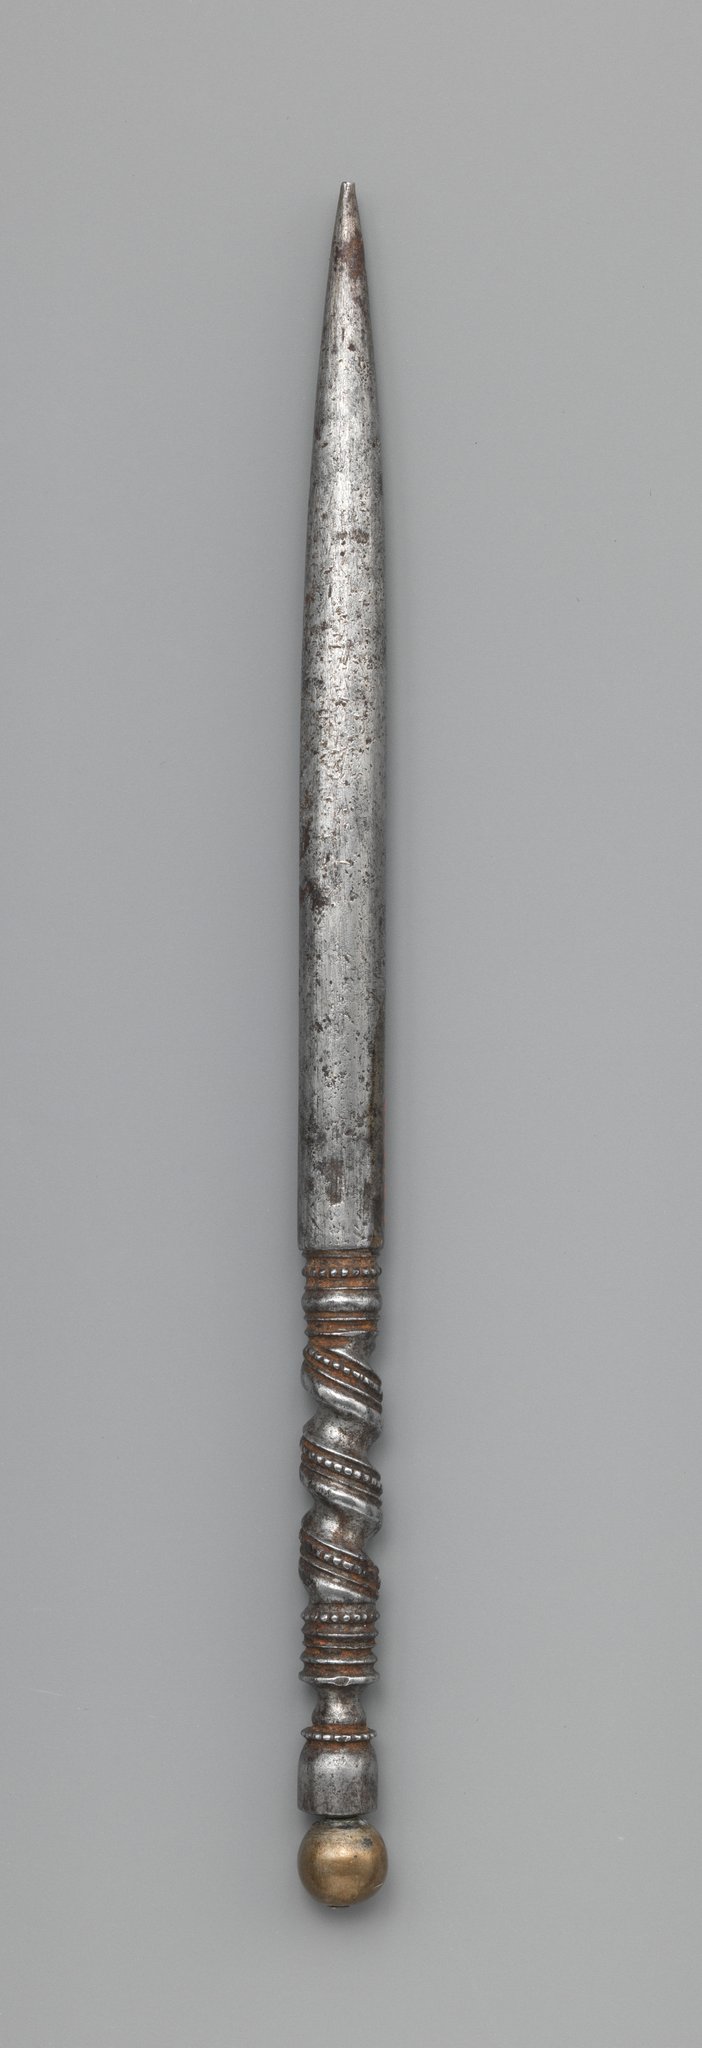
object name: whet steel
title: Whet-steel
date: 1701-1800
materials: steel